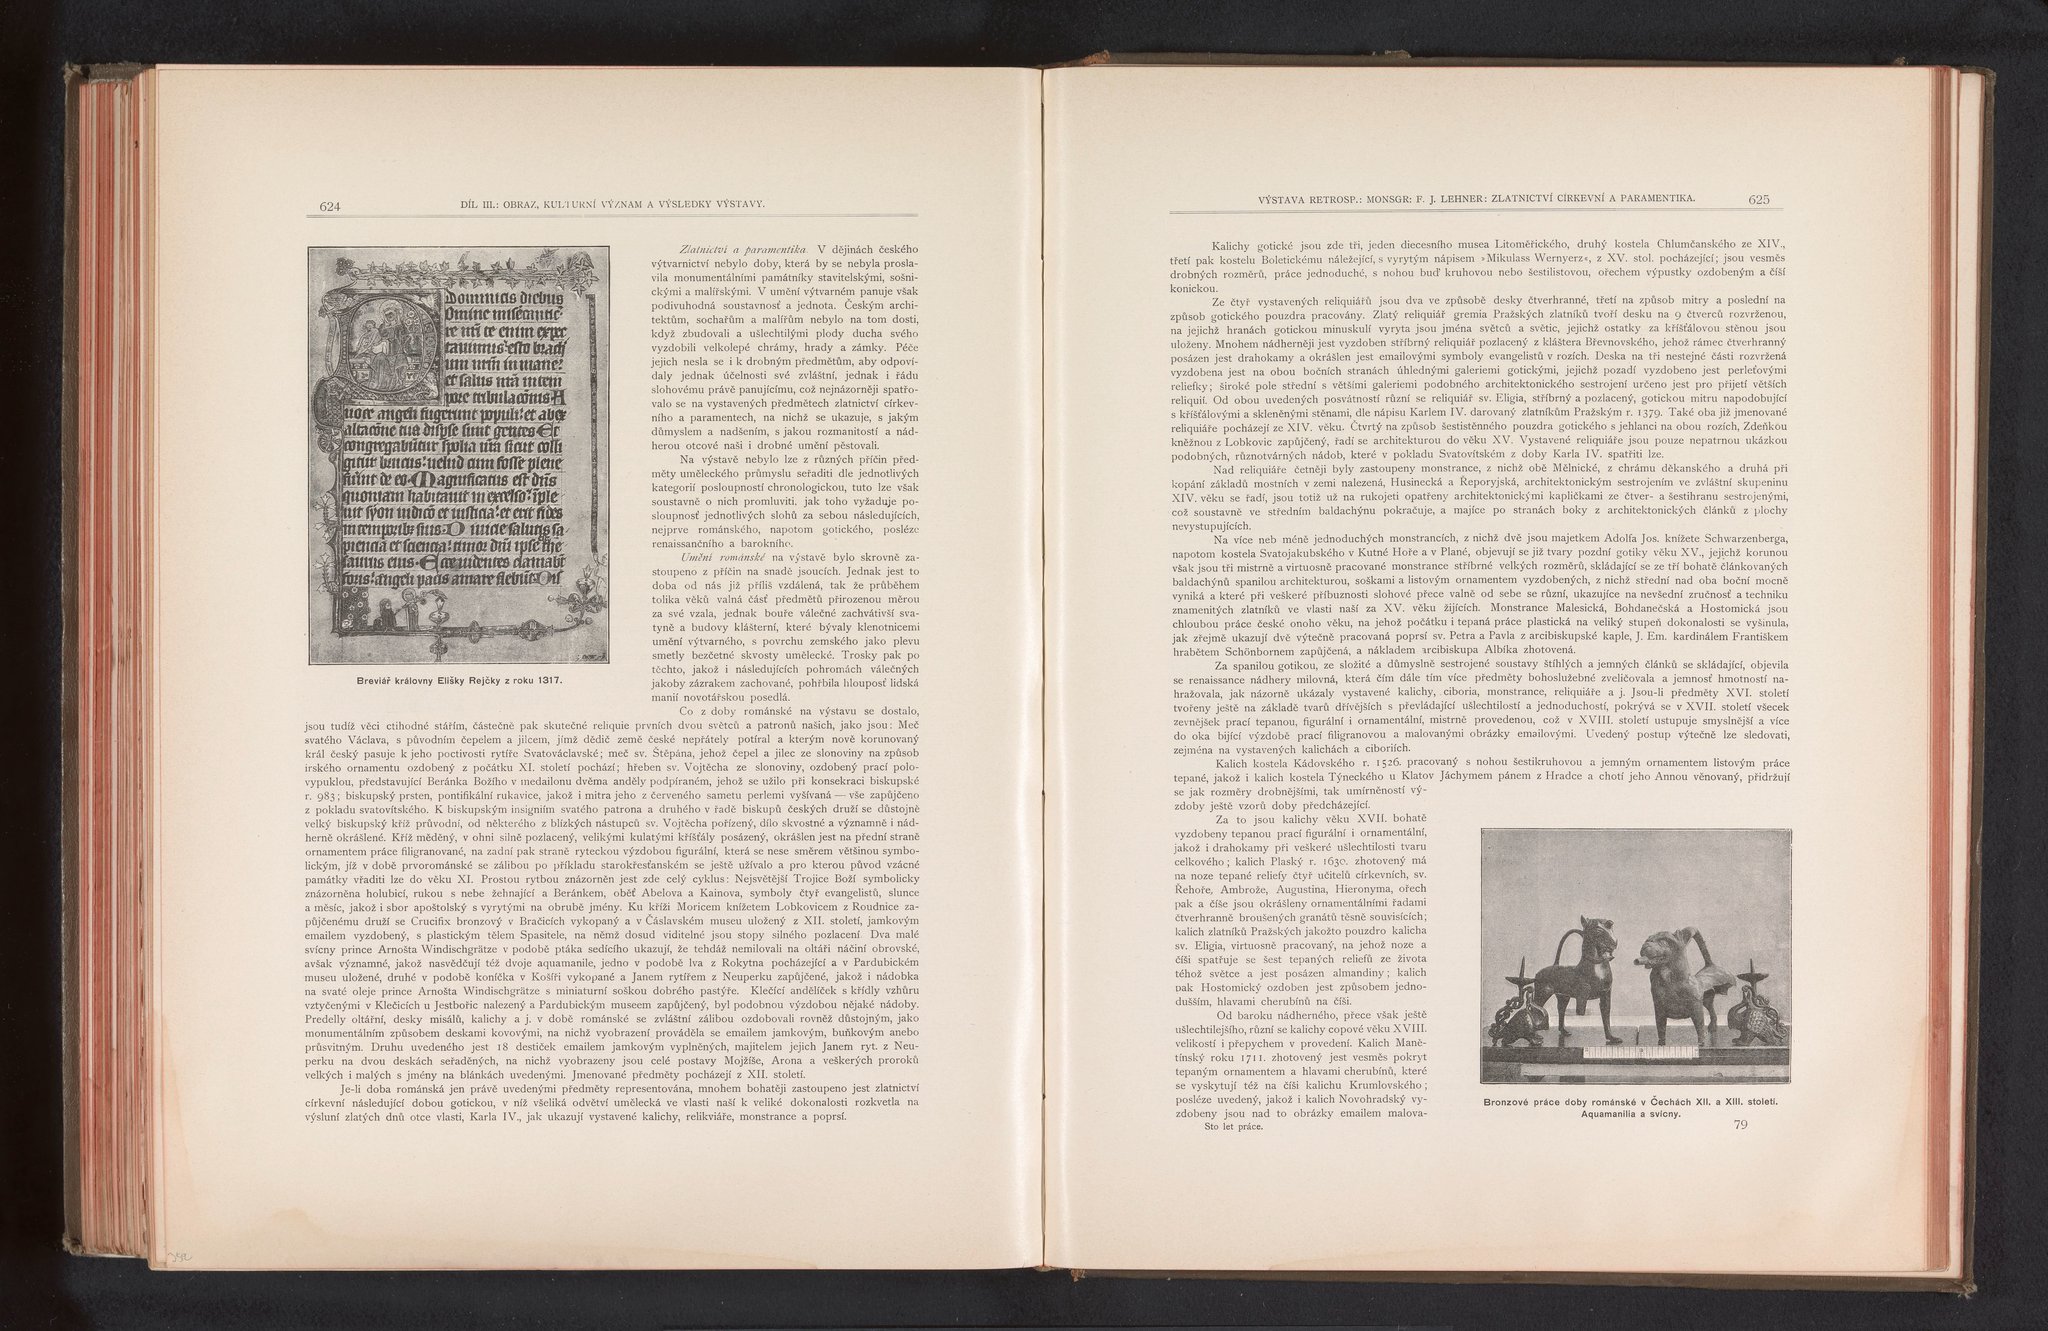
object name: photomechanical print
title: Aquamanile en kandelaars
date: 1891-1895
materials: paper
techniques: autotype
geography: prague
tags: aquamanile, vessel holding water for washing the hands before a meal, candlestick